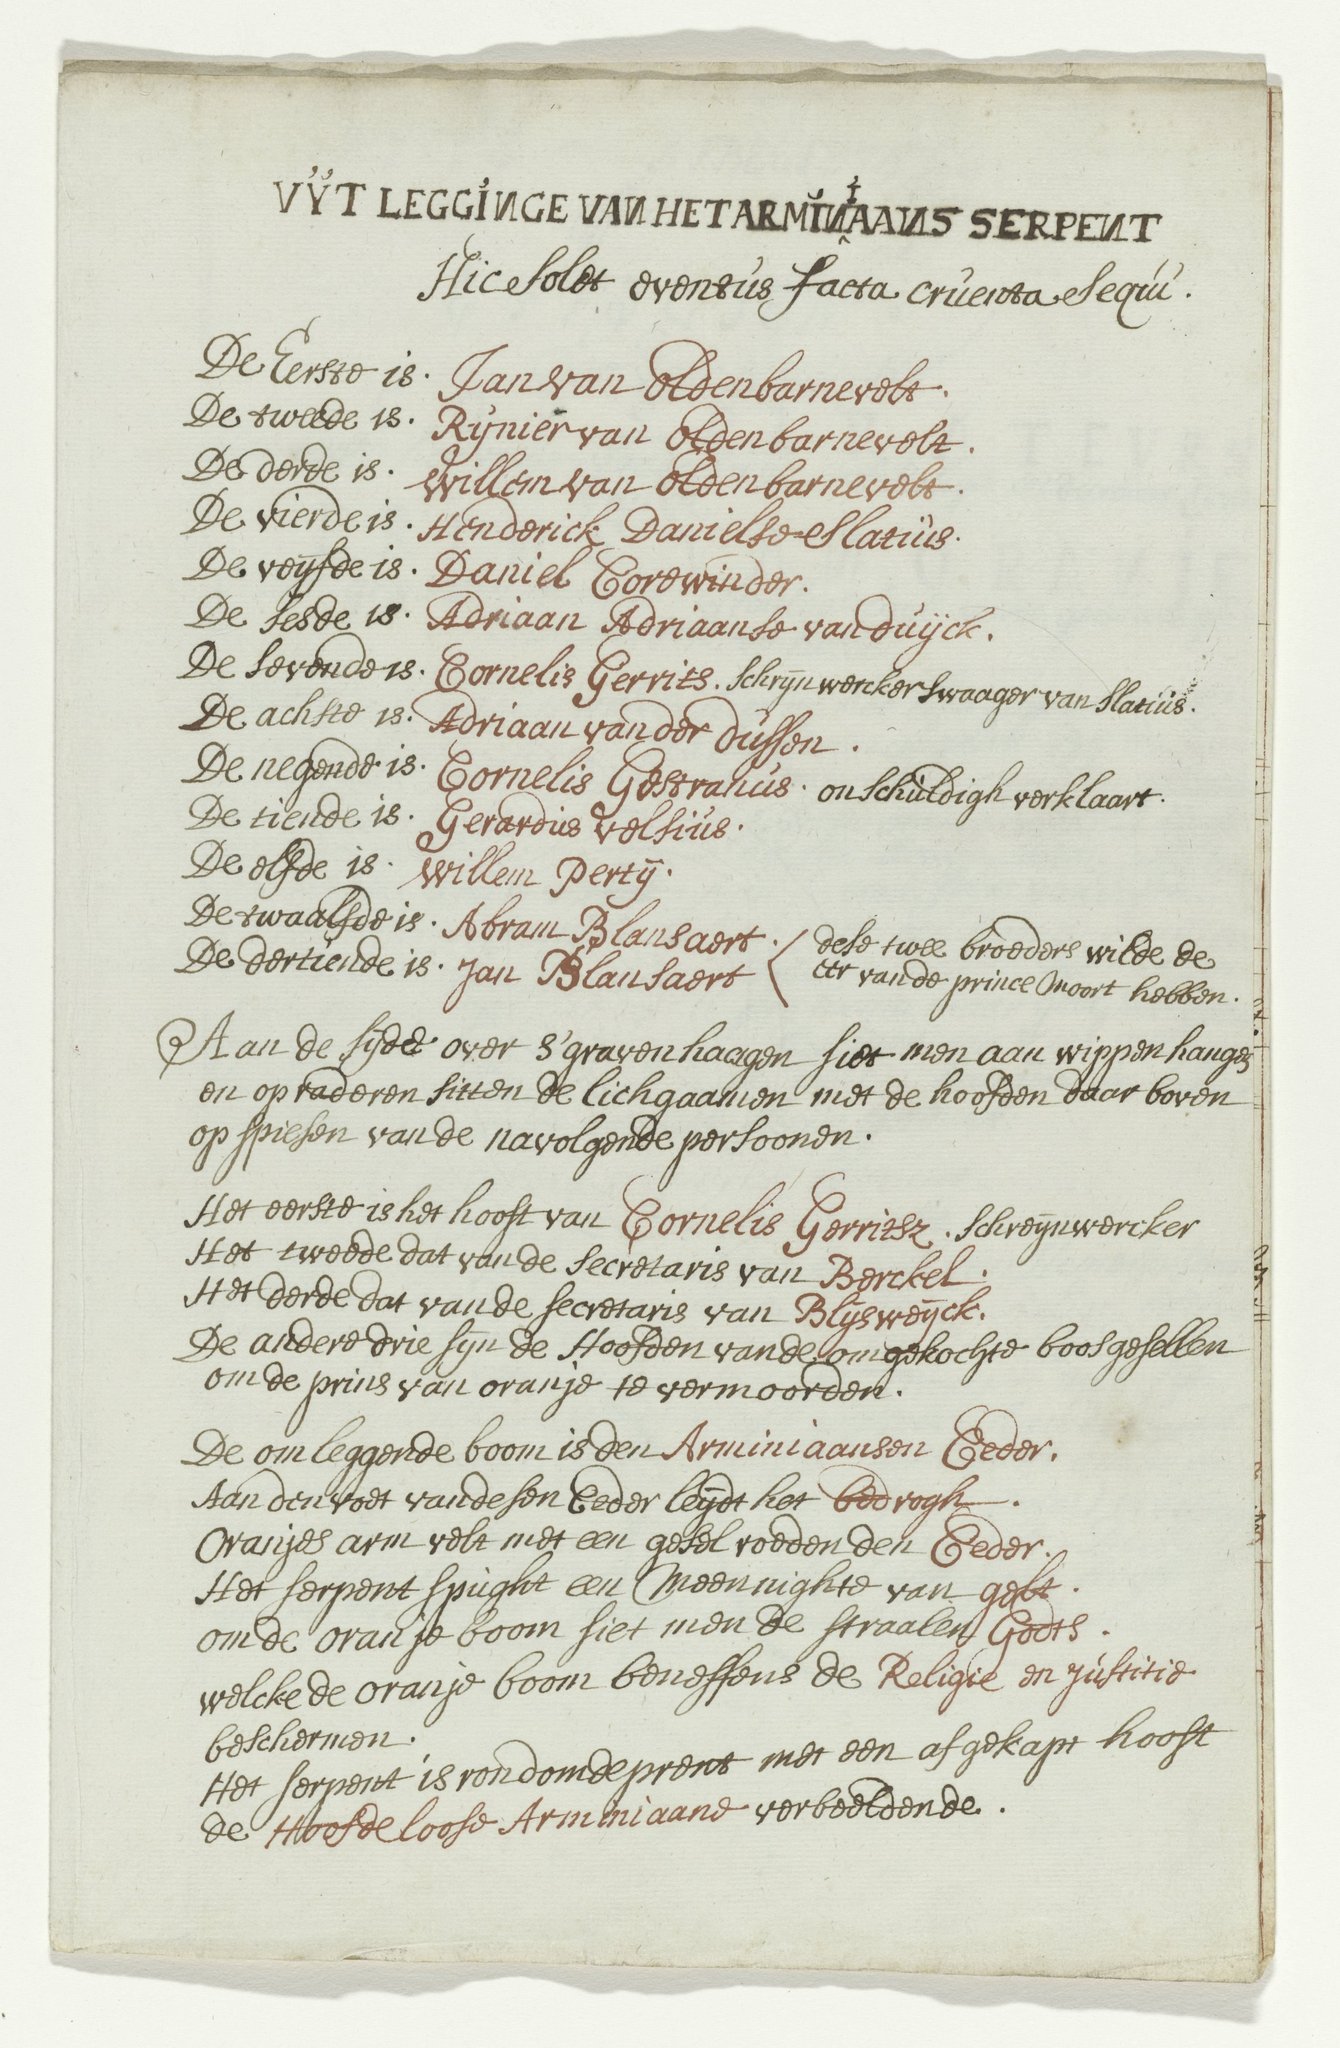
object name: manuscript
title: Regtspleging van Oldenbarnevelt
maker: Anonymous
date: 1710-1720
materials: paper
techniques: pen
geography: netherlands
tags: the hague, johan van oldenbarnevelt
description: Twee en halve dubbelgevouwen bladen met een geschreven toelichting op de voorstelling van de tekening van het Arminiaans Serpent. Behorende bij serie aquarellen in boek.